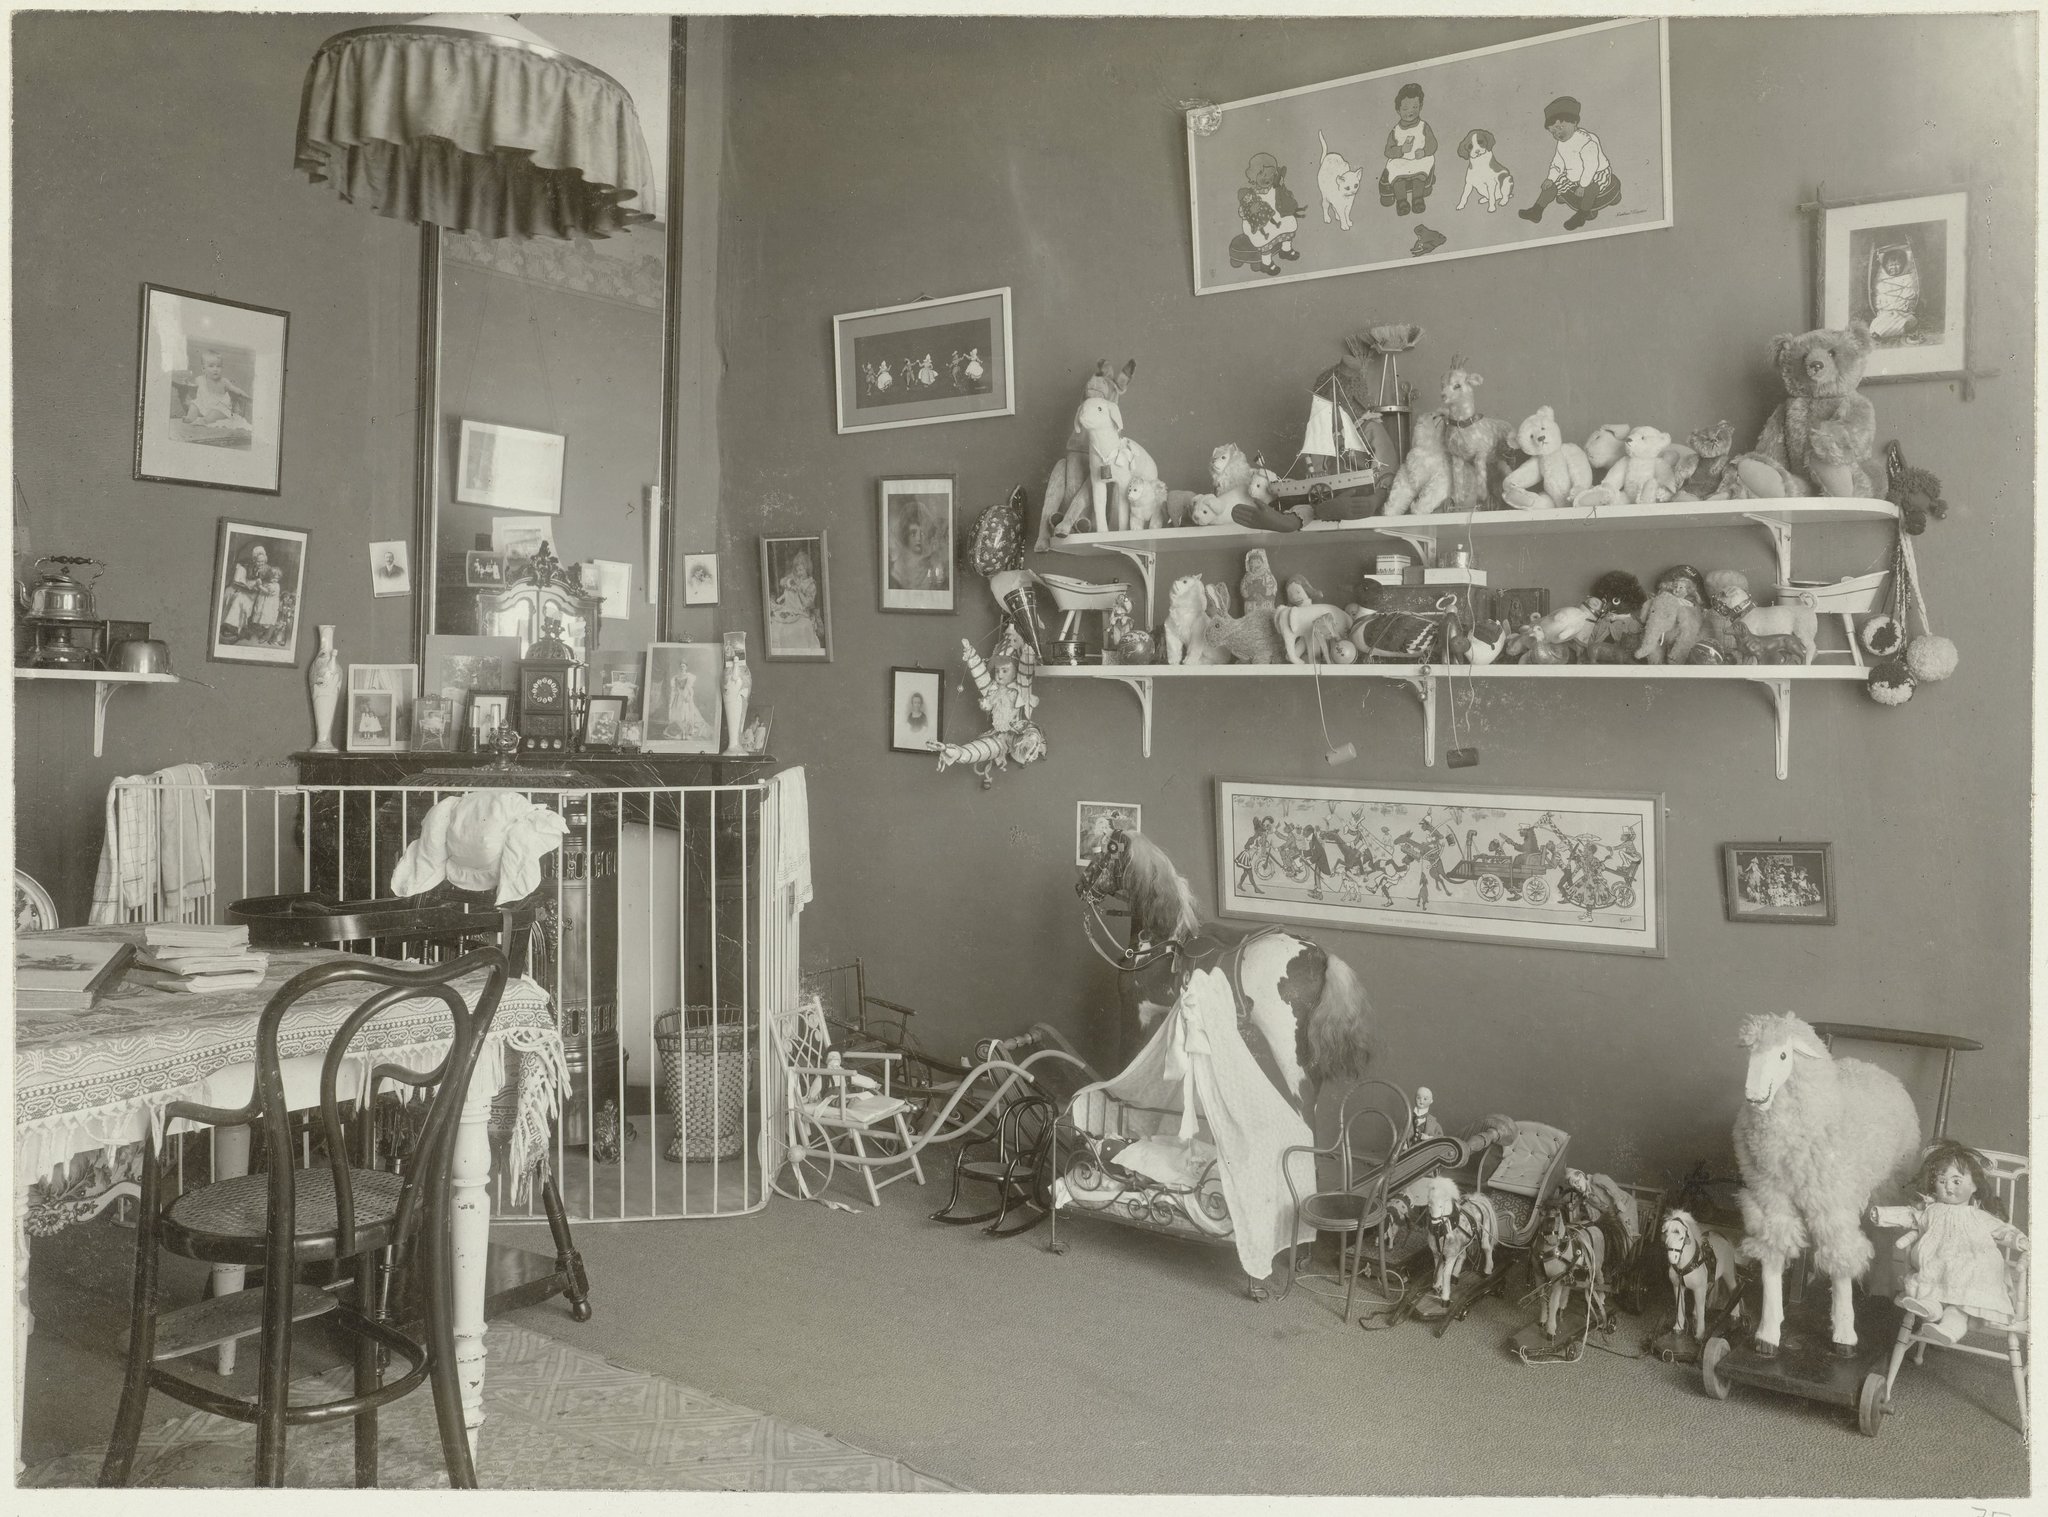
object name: photograph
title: Kamer met kinderhoek in landhuis De Wildbaan, Driebergen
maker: henry pauw van wieldrecht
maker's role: fotograaf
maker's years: 1863-1912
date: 1903-1907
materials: paper, photographic support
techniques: gelatin silver print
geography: netherlands